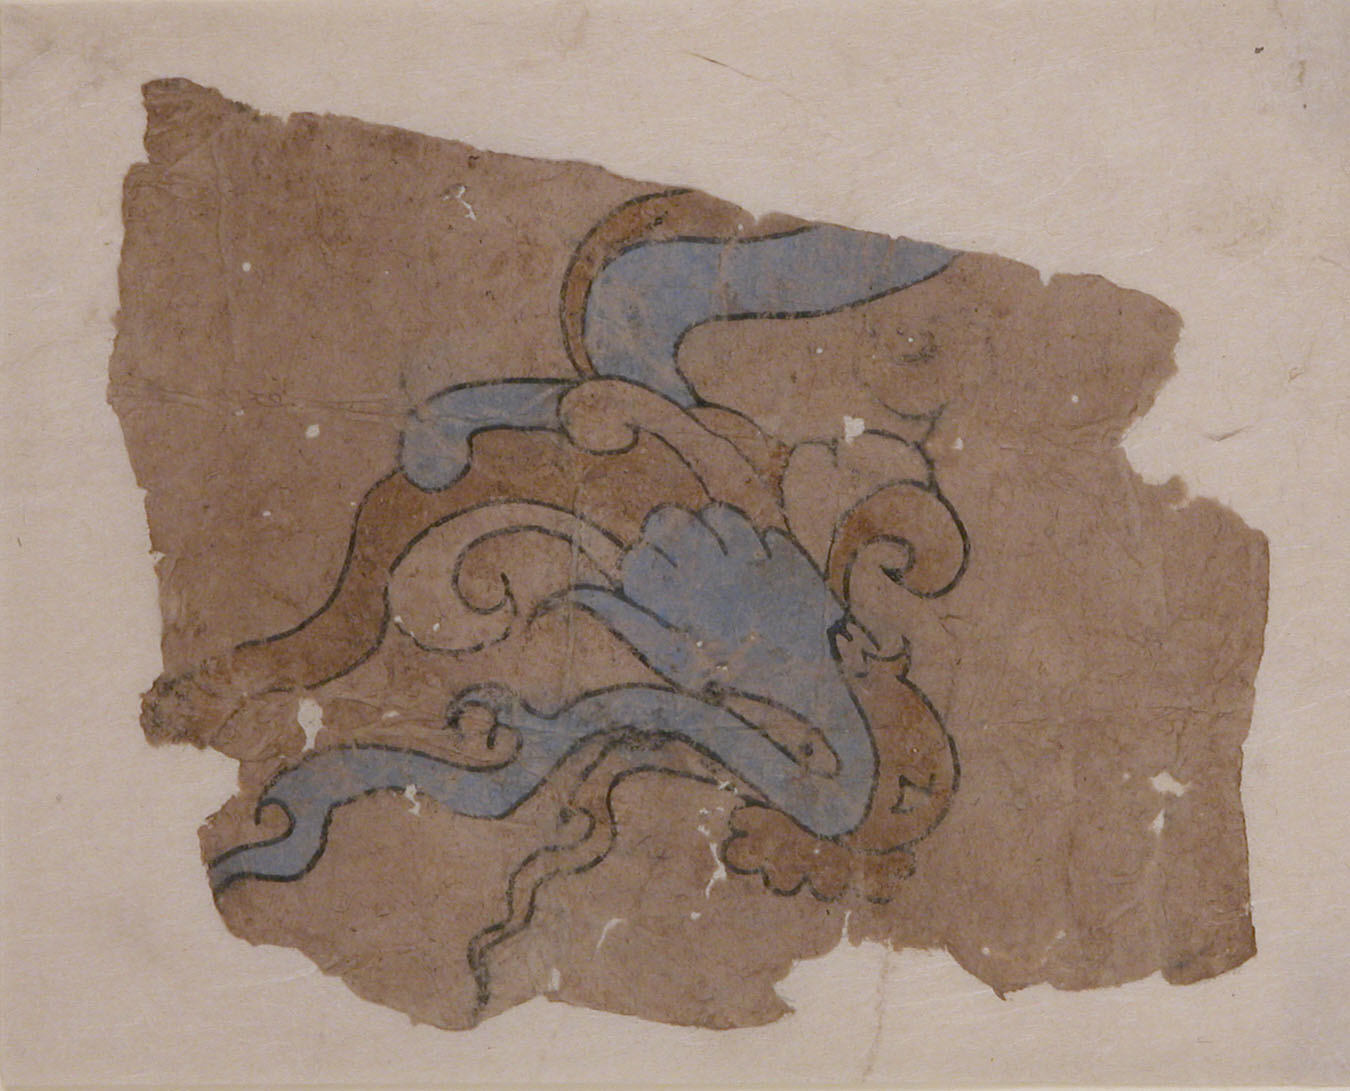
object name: illustrated single work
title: Drawing of the Head of a Simurgh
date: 1301-1400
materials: ink, paper, watercolor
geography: egypt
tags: heads,mythical creatures